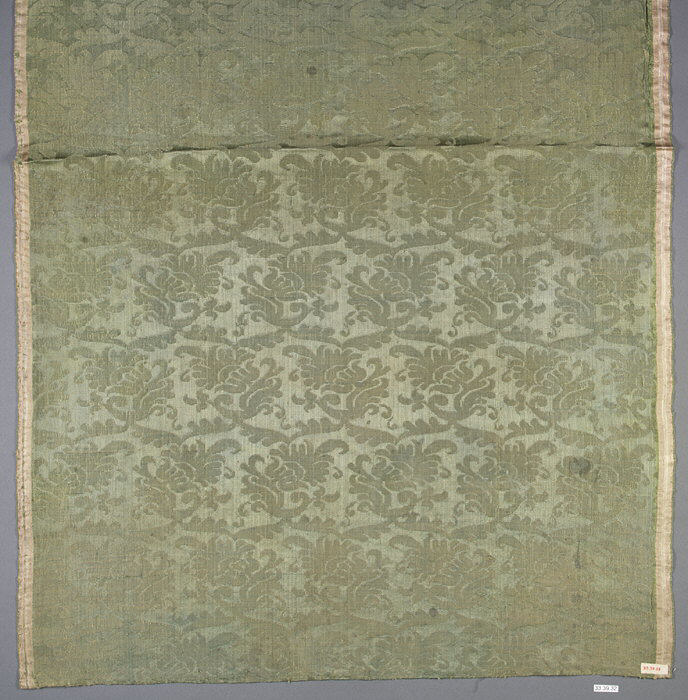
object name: piece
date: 1601-1700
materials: silk